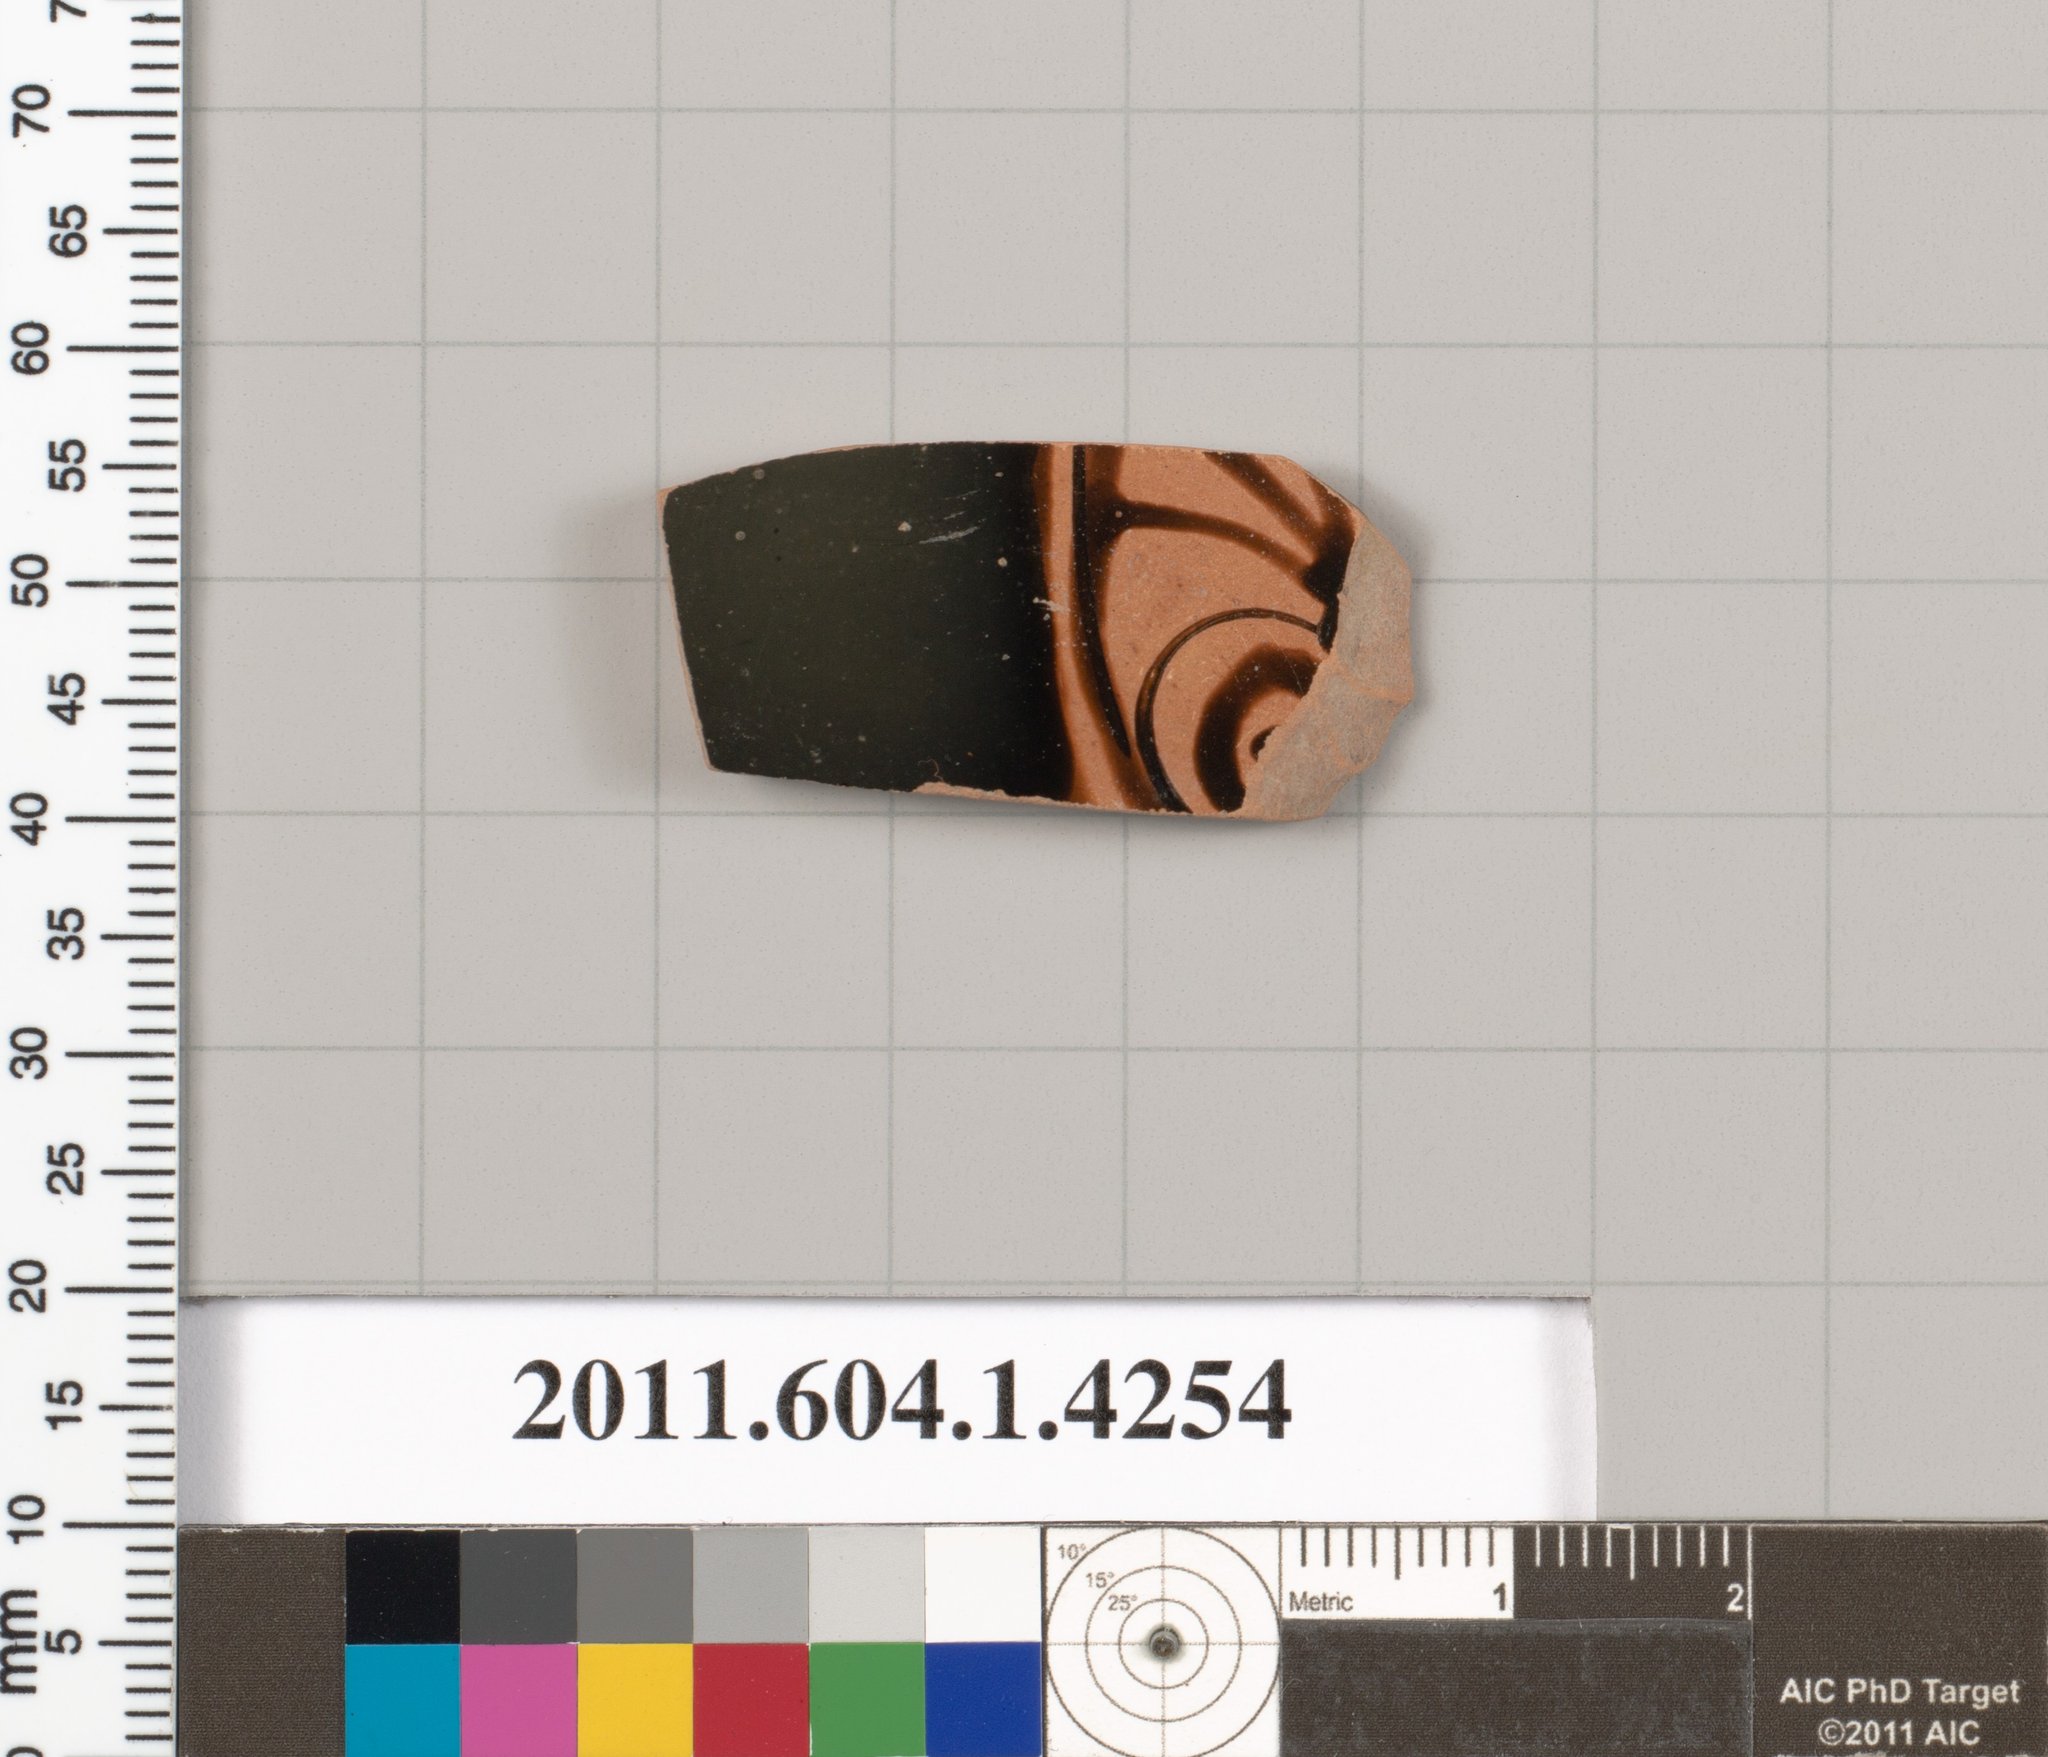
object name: kylix fragment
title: Terracotta fragment of a kylix (drinking cup)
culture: greek, attic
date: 467-435 BCE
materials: terracotta